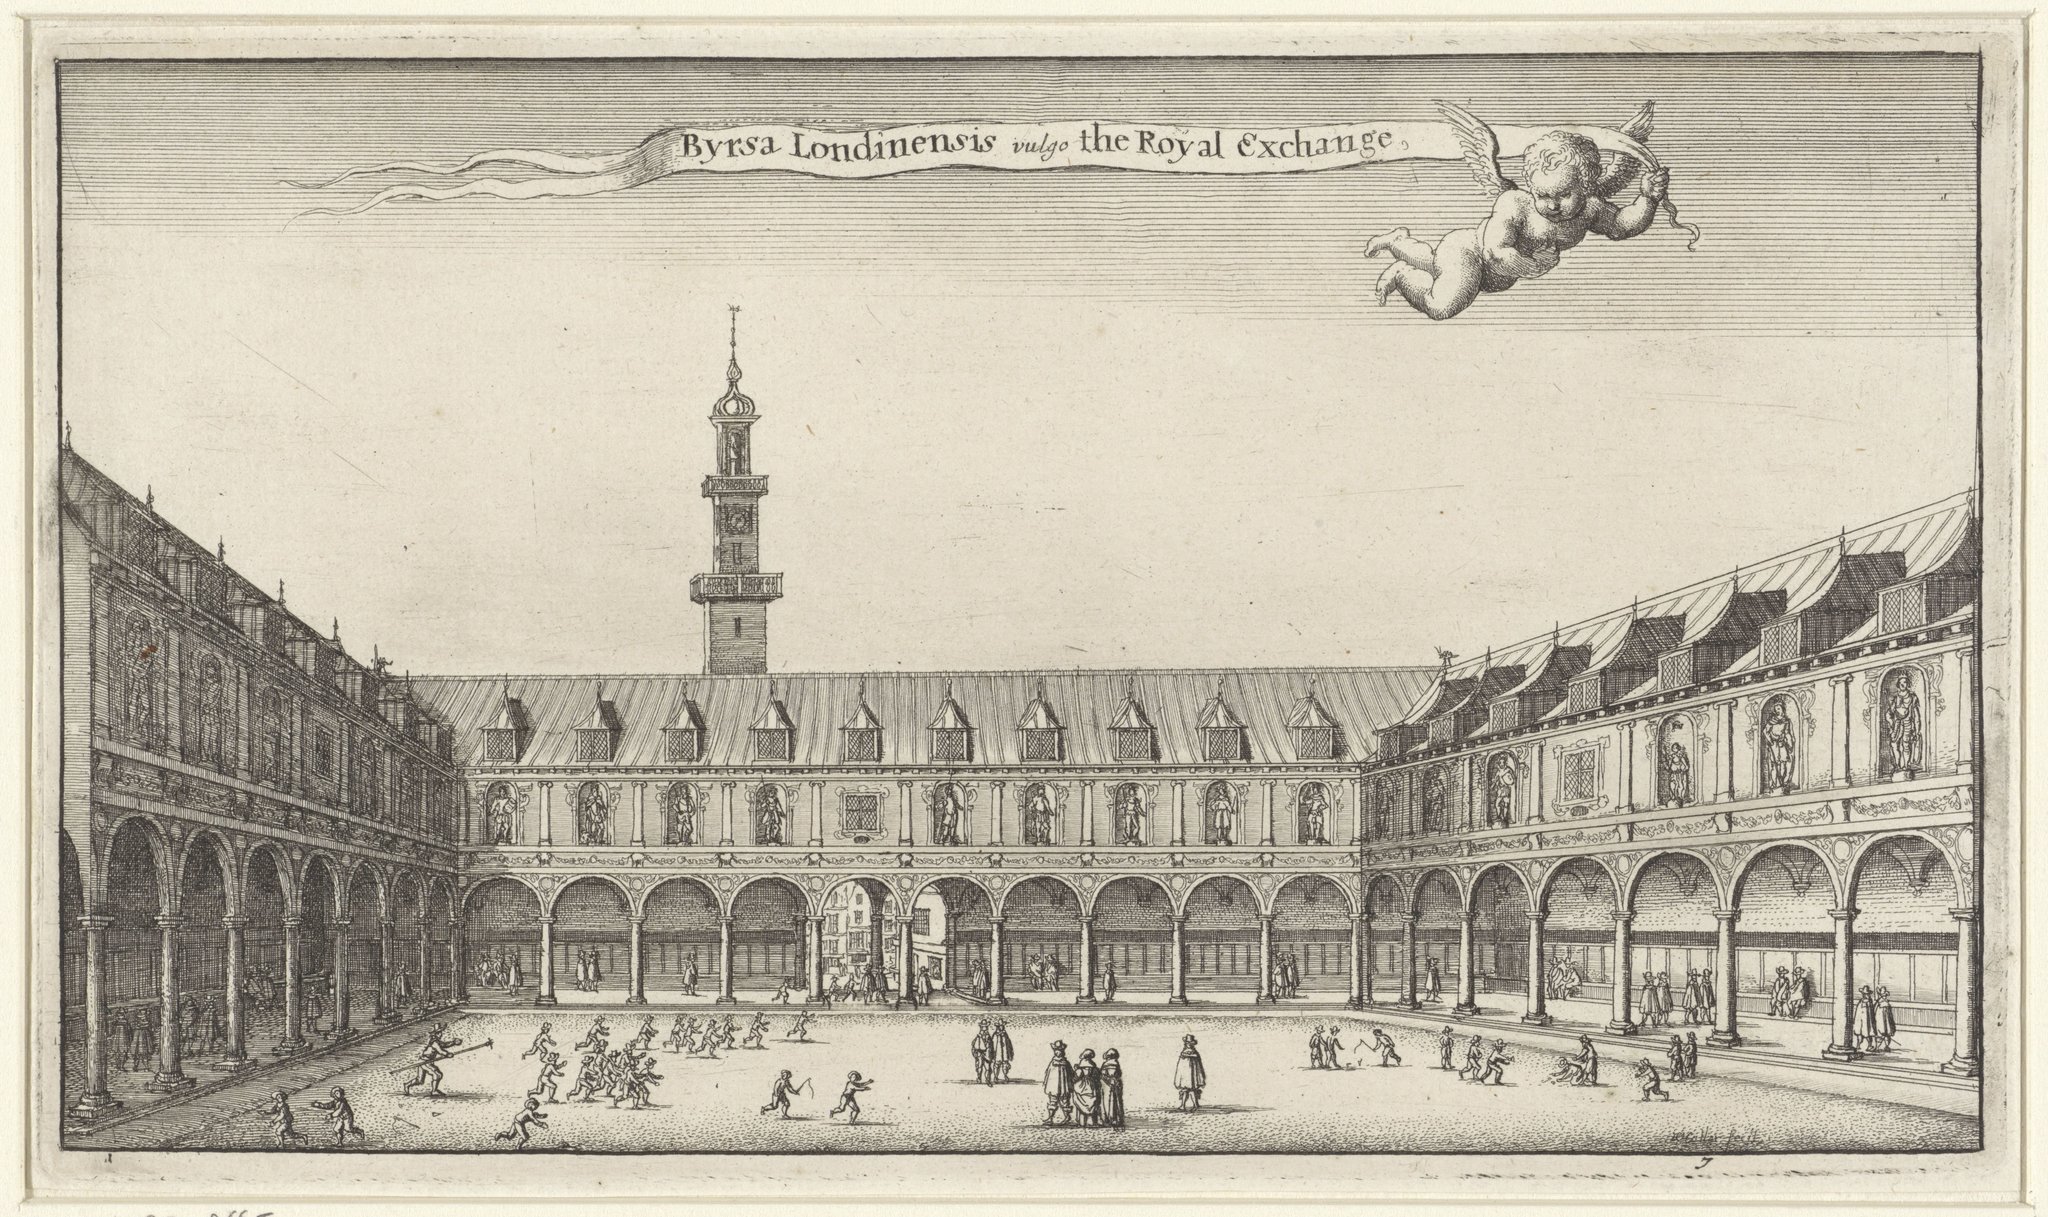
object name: print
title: Byrsa Londinensis vulgo the Royal Exchange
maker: wenceslaus hollar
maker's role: draughtsman, print maker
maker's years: 1607-1677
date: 1647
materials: paper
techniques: etching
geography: antwerp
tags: stock exchange, stock-market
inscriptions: collector's mark: Lugt 654, collector's mark: Lugt 1227